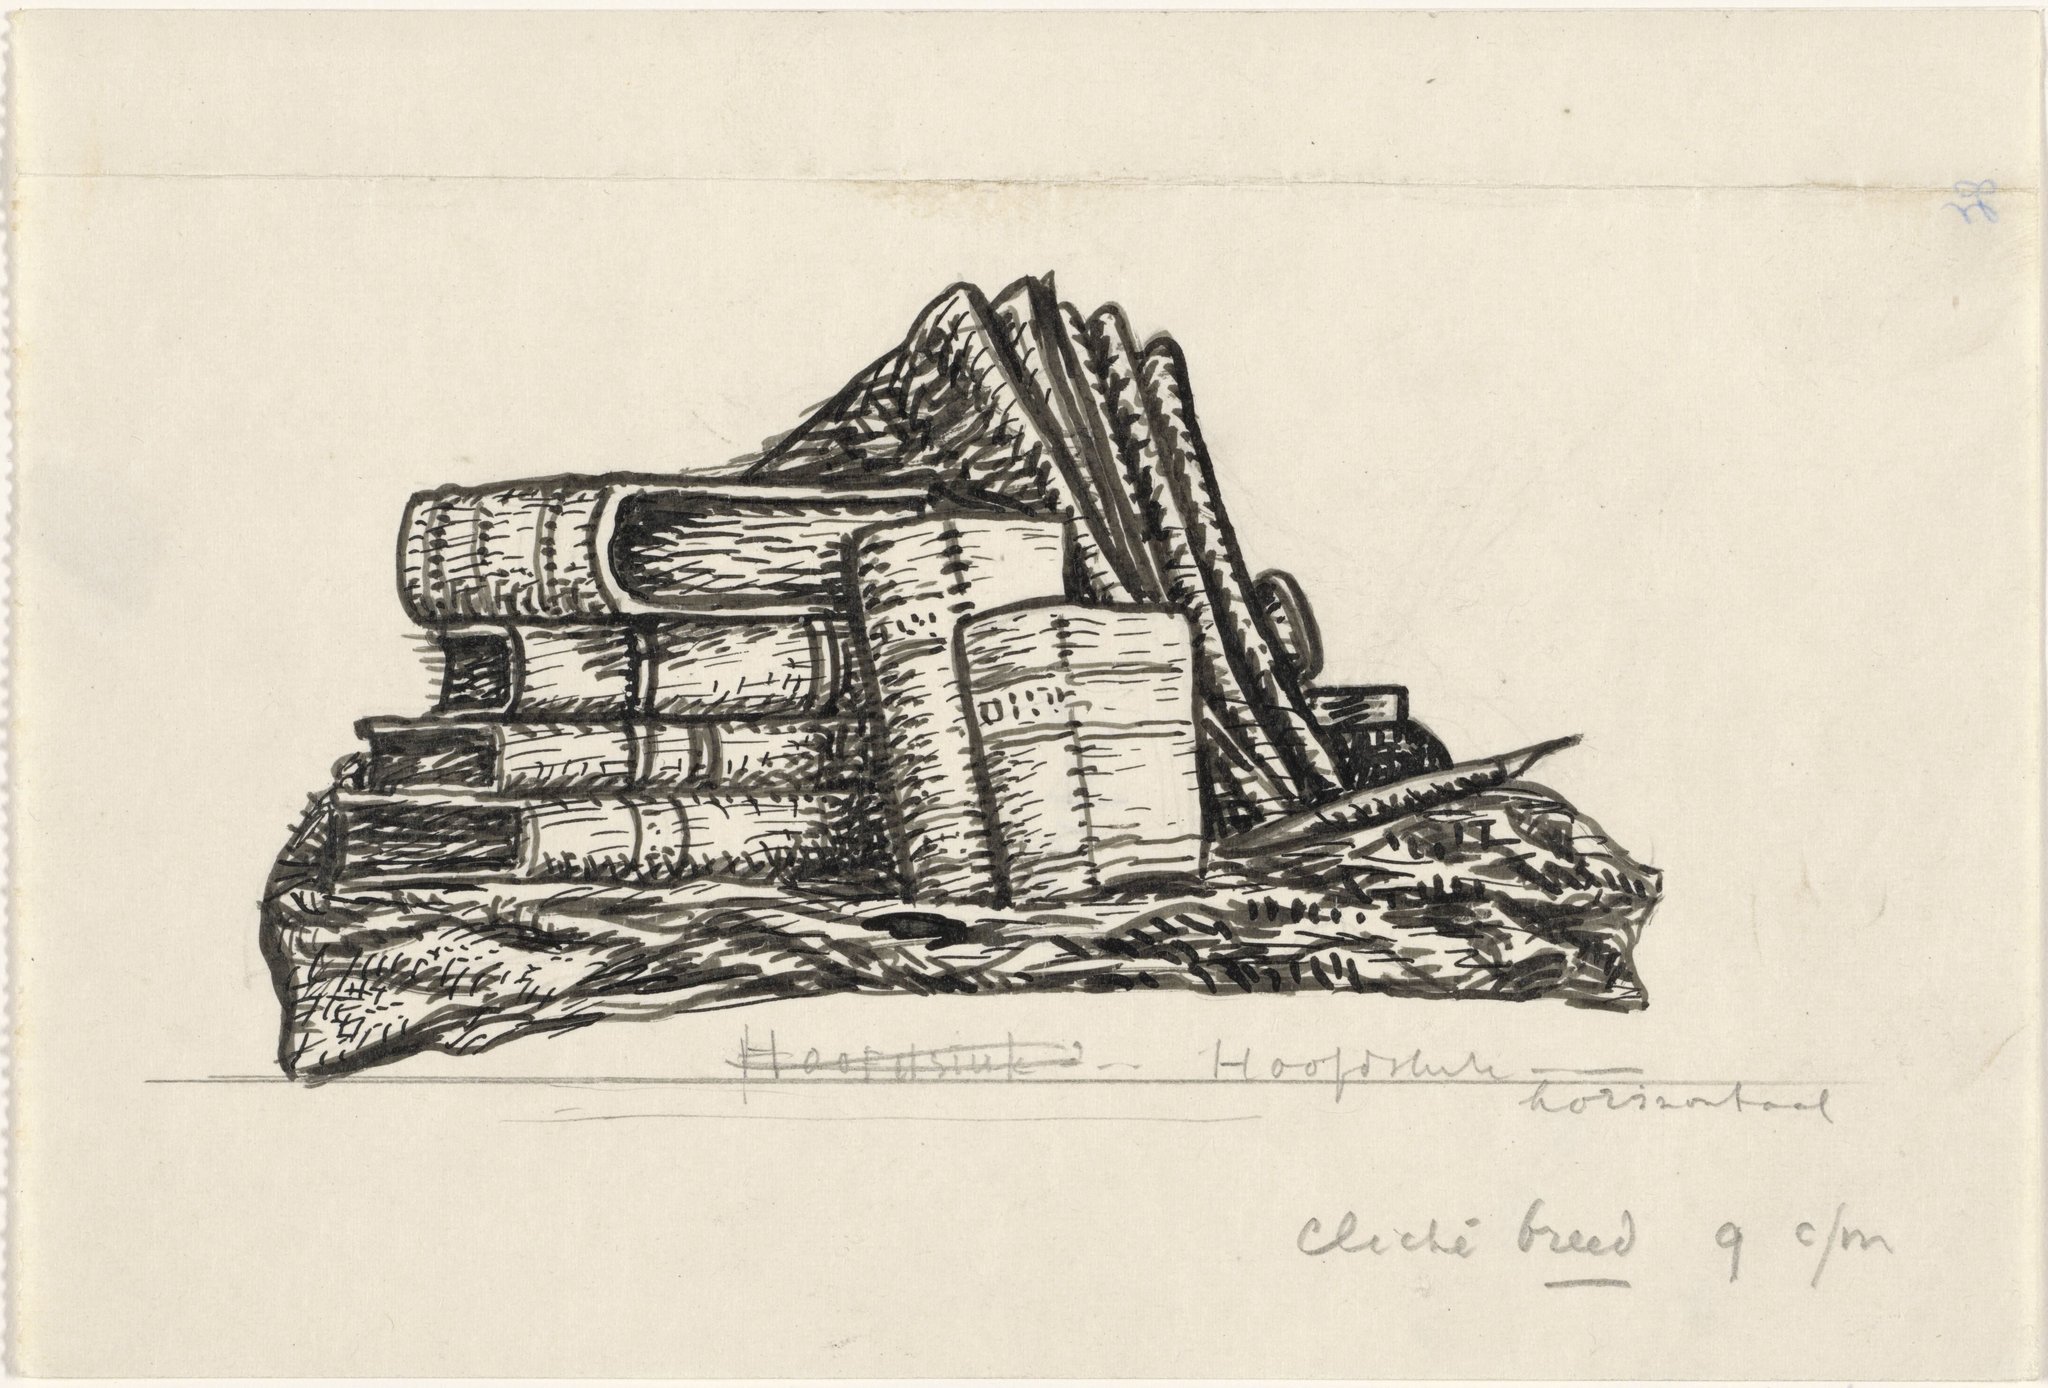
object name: boekillustratie ontwerp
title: Stapel boeken en schrijfwaren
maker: leo gestel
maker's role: draughtsman, print maker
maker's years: 1881-1941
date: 1934-1936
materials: ink, paper, pencil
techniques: brush, pen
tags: (cohen, van anarchist tot monarchist) specific works of literature (with author, title), book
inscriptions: clichéaanwijzing, recto, handgeschreven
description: Ontwerp voor een boekillustratie voor: Cohen, Alexander. Van anarchist tot monarchist. Amsterdam: De Steenuil, 1936.